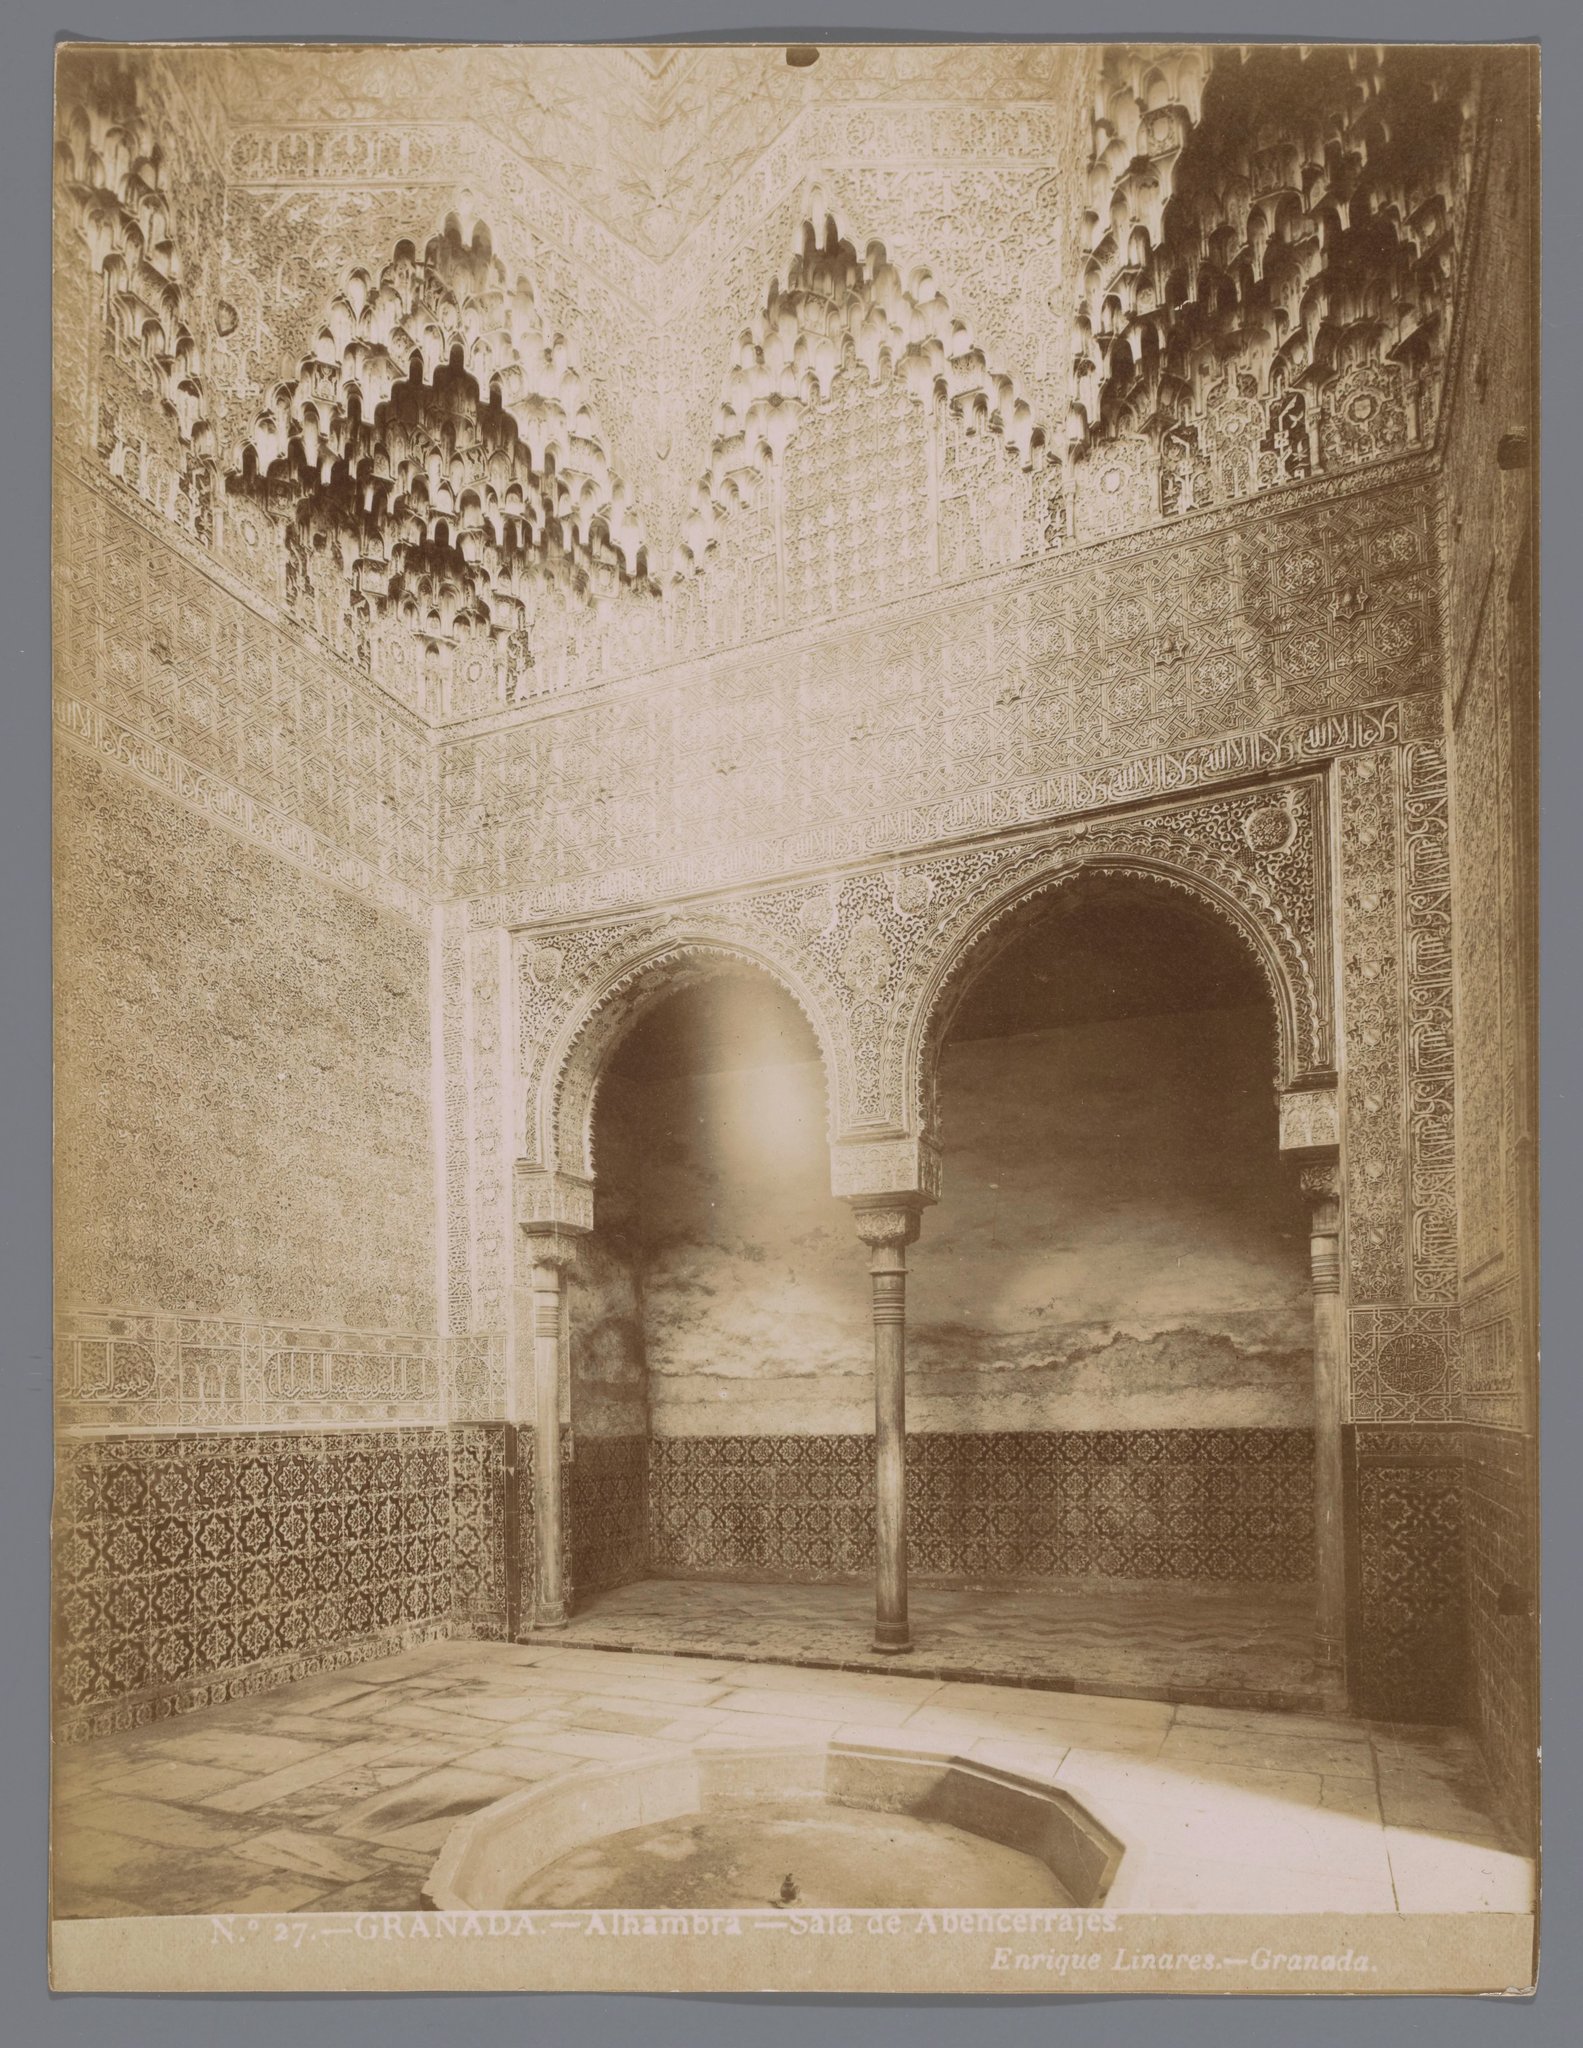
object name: photograph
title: Sala de los Abencerrajes in het Alhambra van Granada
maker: enrique linares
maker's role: fotograaf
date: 1900-1930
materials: paper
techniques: gelatin silver print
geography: granada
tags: palace - aa - civic architecture: inside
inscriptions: number: ‘No 27.’